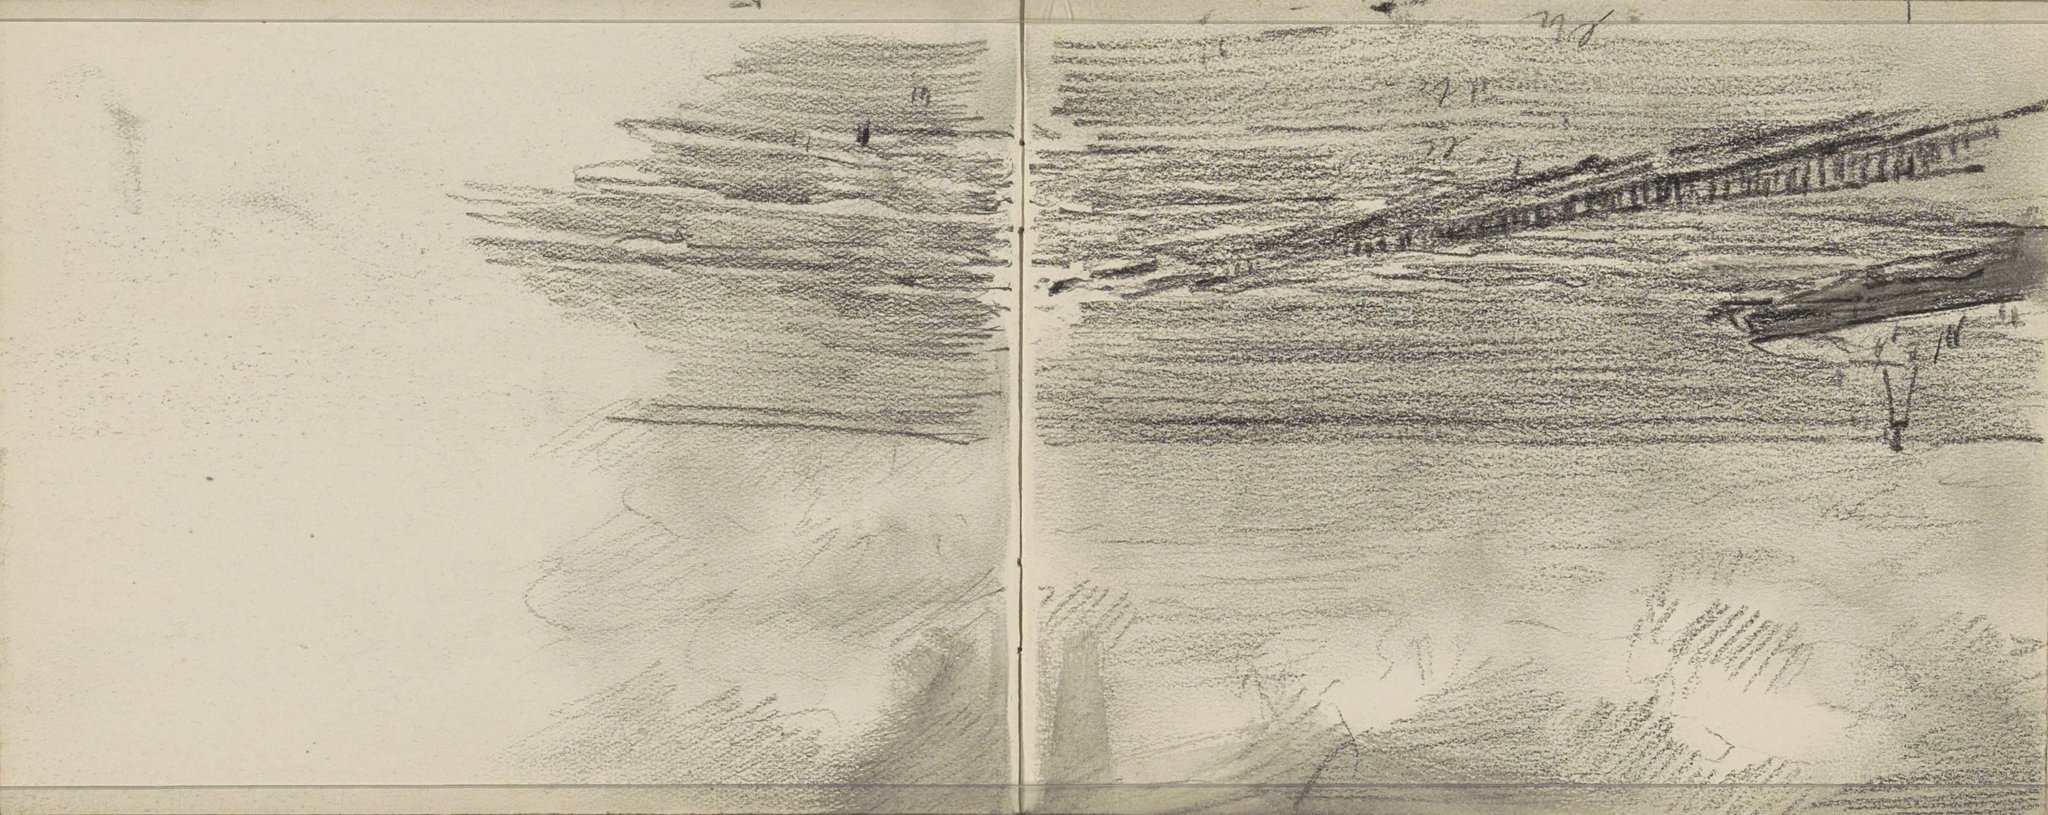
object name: sketchbook leaf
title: Zeegezicht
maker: johan antonie de jonge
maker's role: draughtsman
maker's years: 1864-1927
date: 1881-1927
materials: chalk, paper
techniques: stumping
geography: south holland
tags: sea (seascape)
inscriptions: kleurnotitie, handgeschreven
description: Zeegezicht. Blad 8 verso en blad 9 recto uit een schetsboek met 29 bladen.